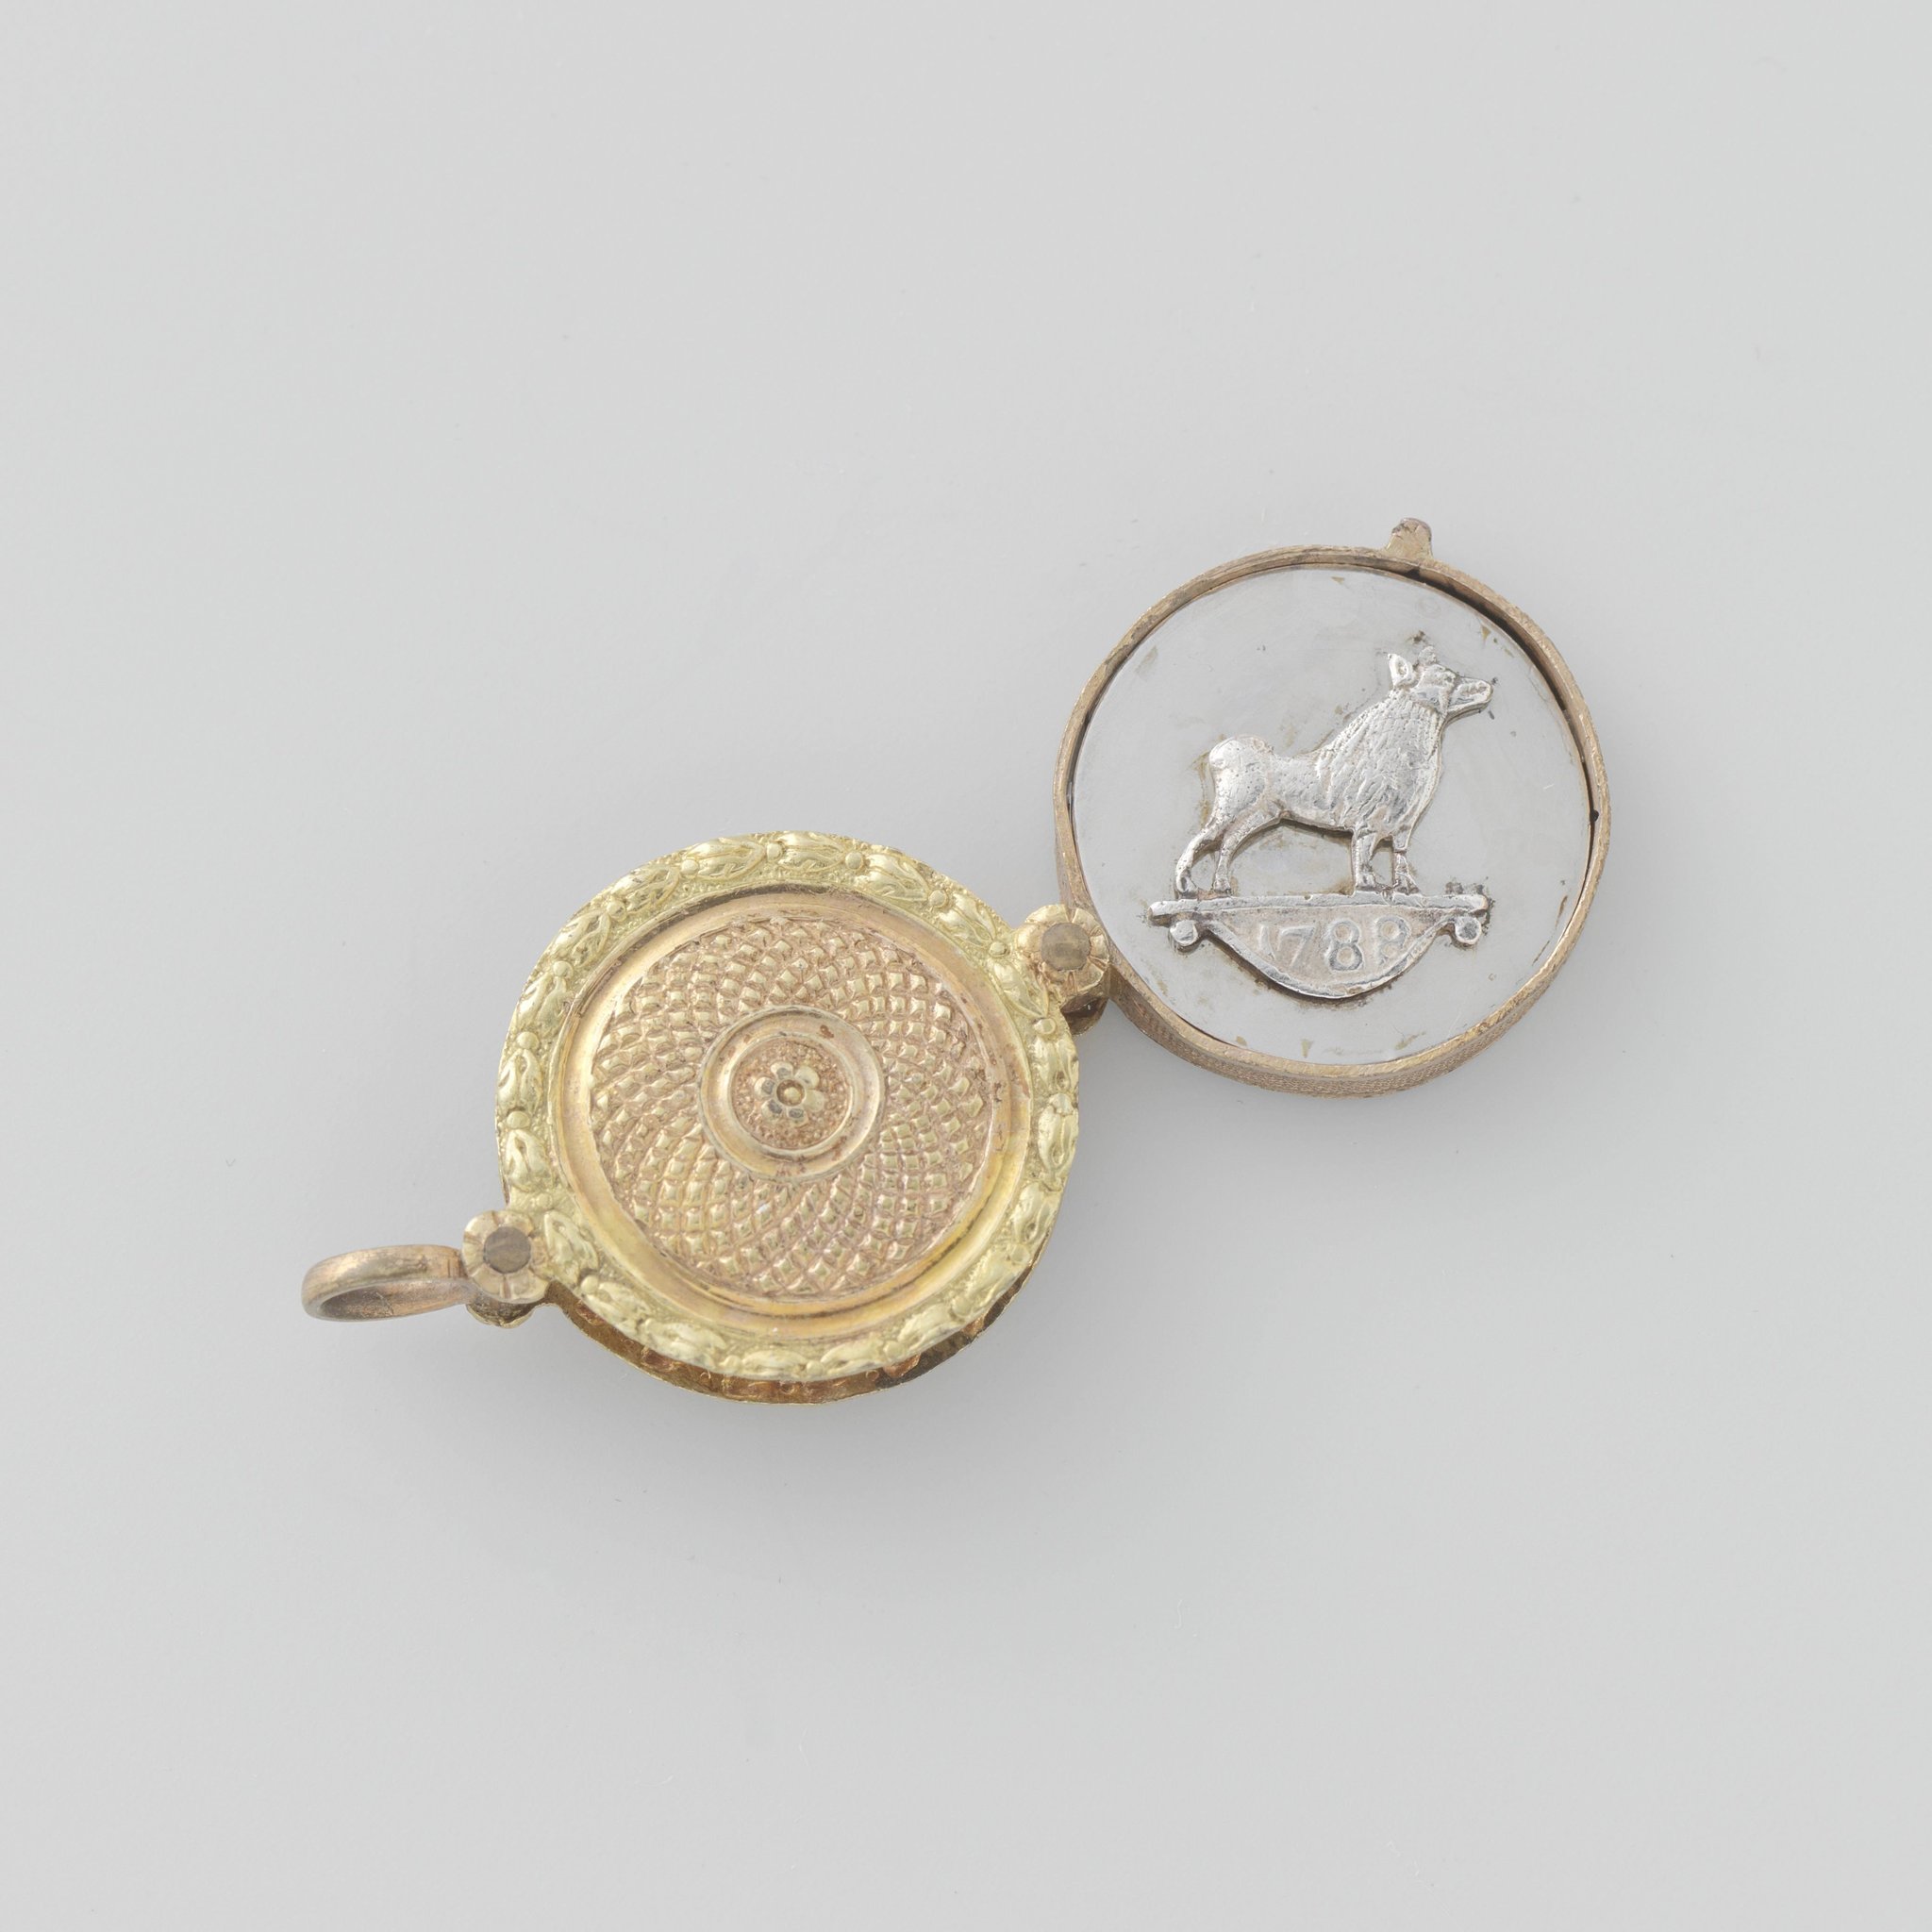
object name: case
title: Keeshondje, draagteken ter ere van Hendrik Danielsz. Hooft, burgemeester van Amsterdam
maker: Anonymous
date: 1788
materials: copper, silver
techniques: engraving, fastening, gilding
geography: netherlands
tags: amsterdam, mayor, hendrik danielsz. hooft, dog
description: Badge with spitz dog.